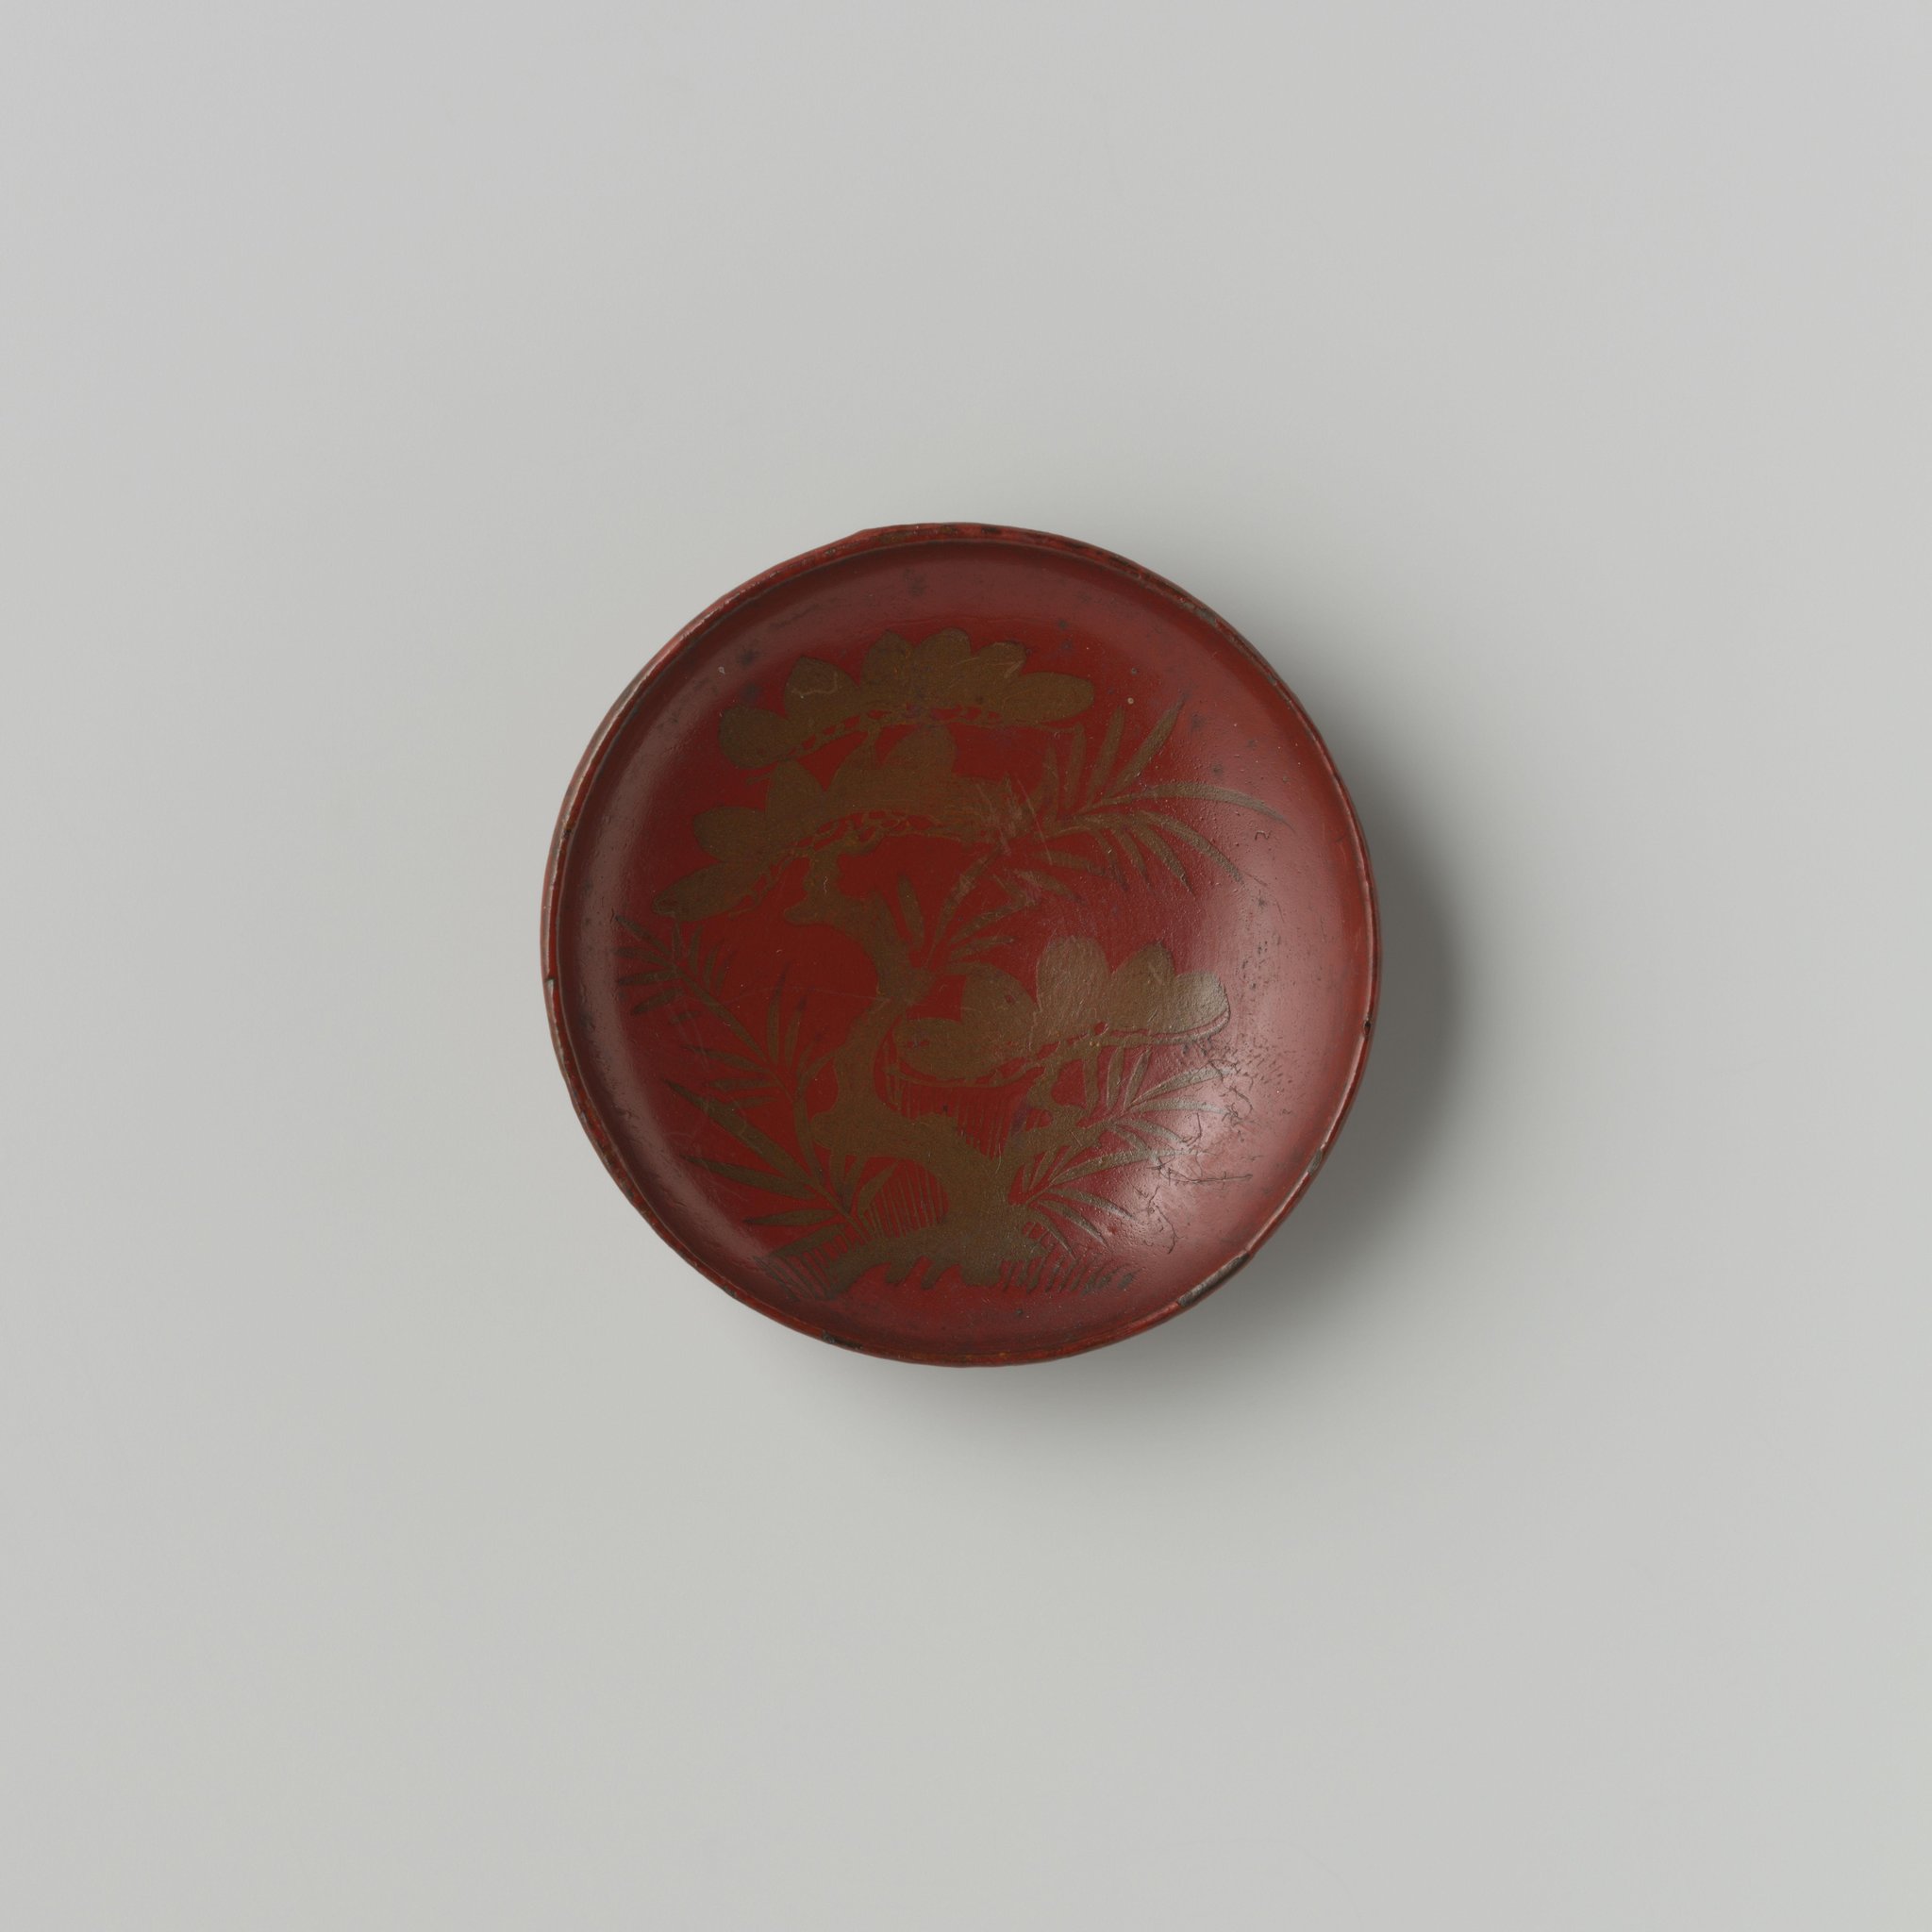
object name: miniature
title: Ronde schotel, gedraaid van hout en geheel bedekt met een rode laklaag; decoratie van bloemrank in goudverf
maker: Anonymous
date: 1690-1710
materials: wood, paint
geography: amsterdam